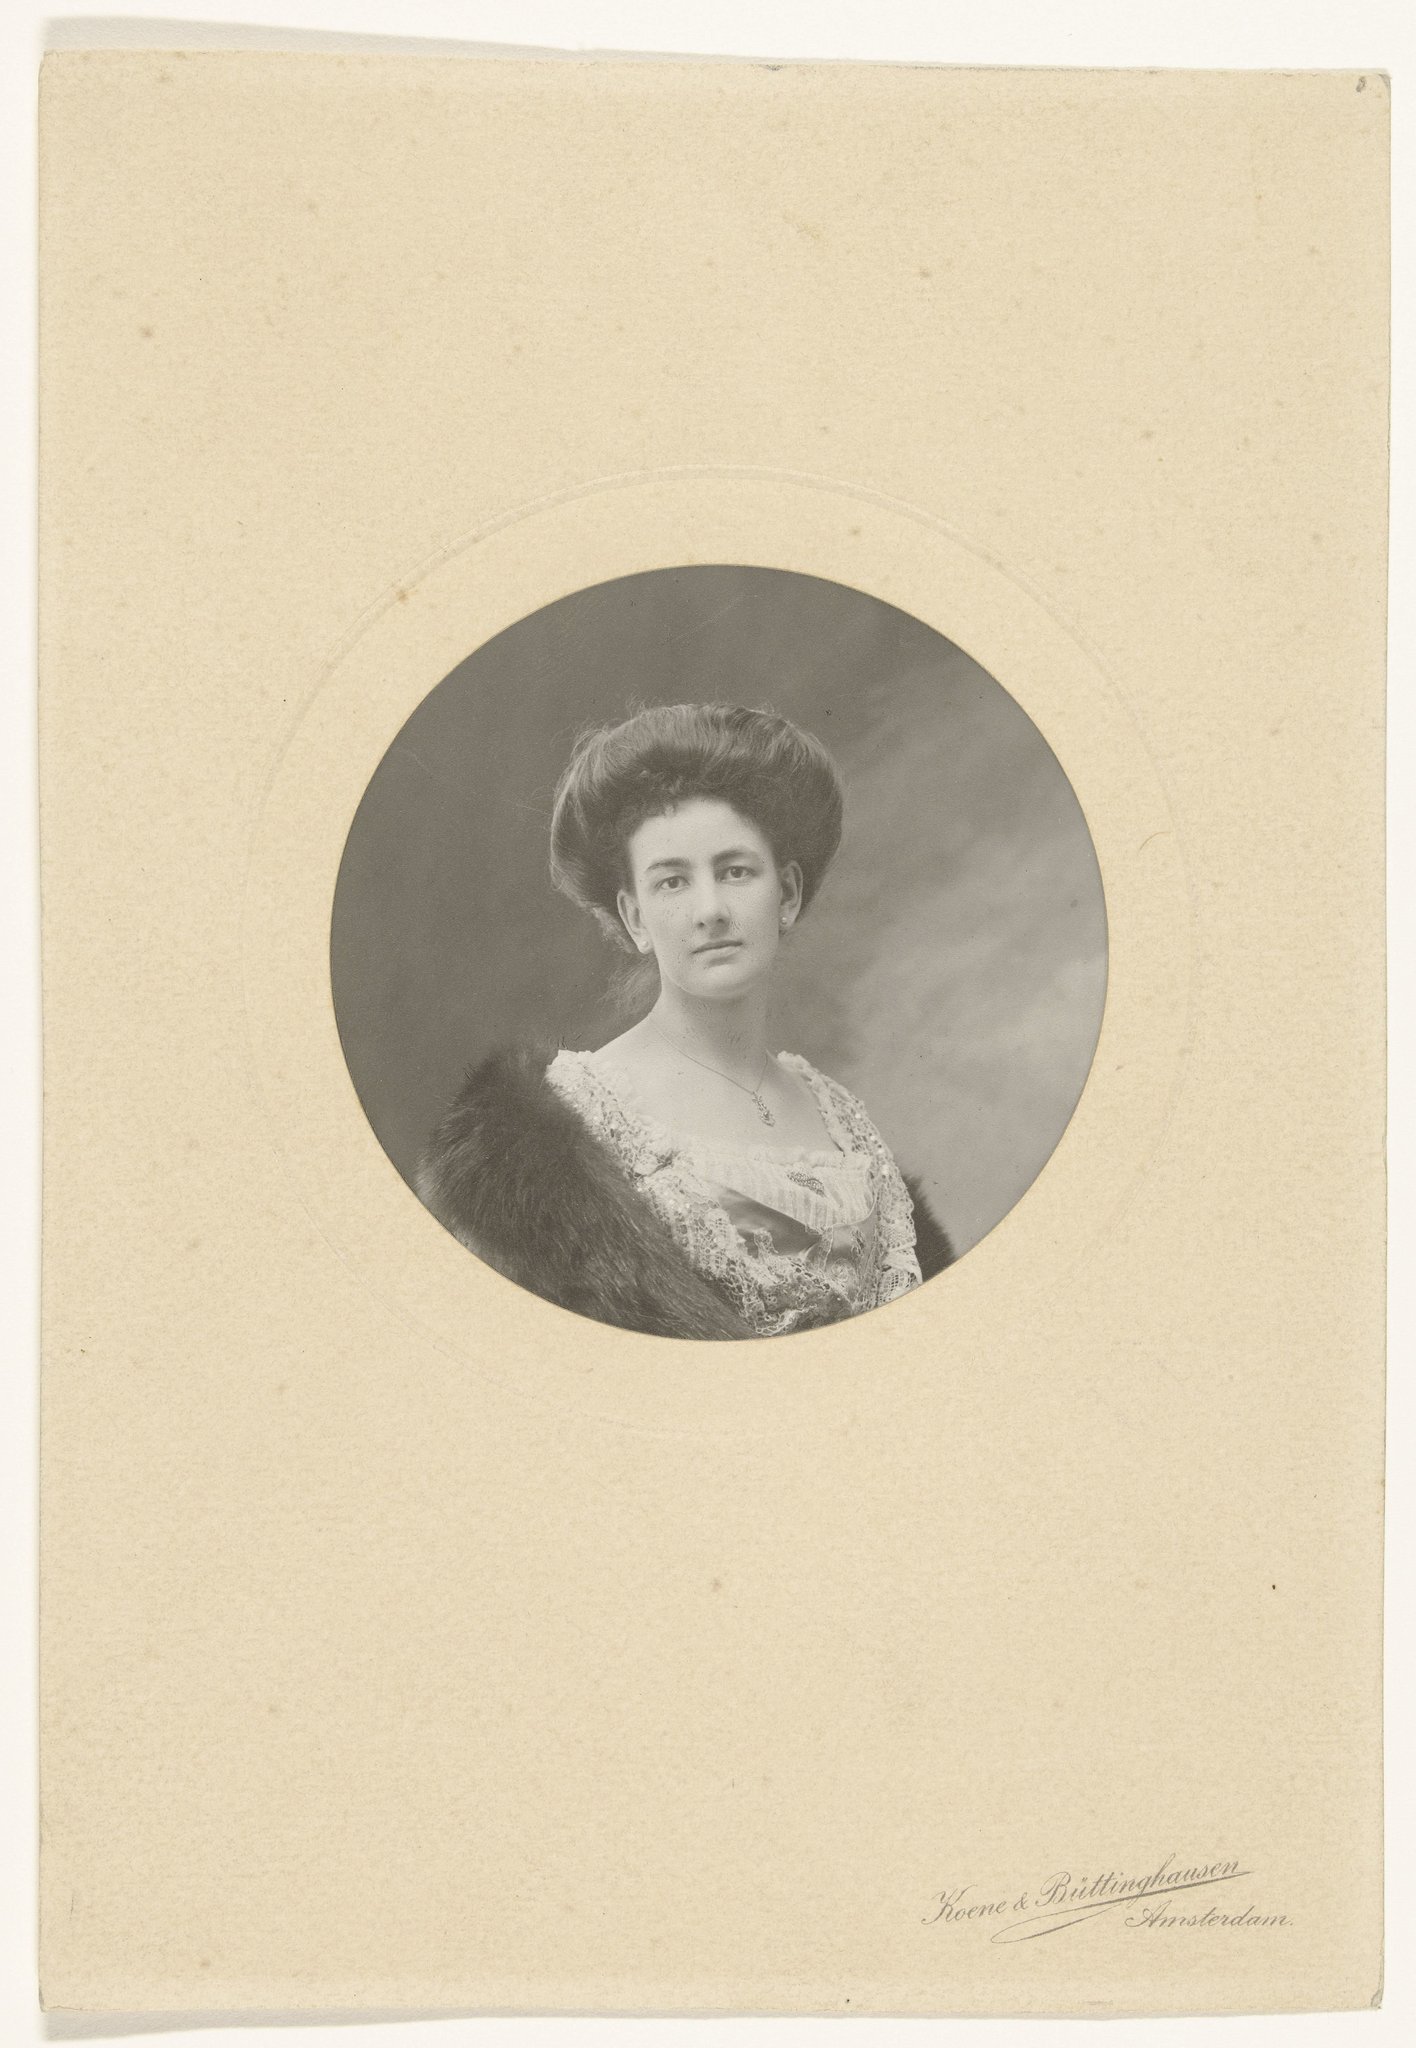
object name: photograph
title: Ida v. Braam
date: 1900-1920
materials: cardboard, paper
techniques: gelatin silver print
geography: amsterdam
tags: historical persons - bb - woman, netherlands